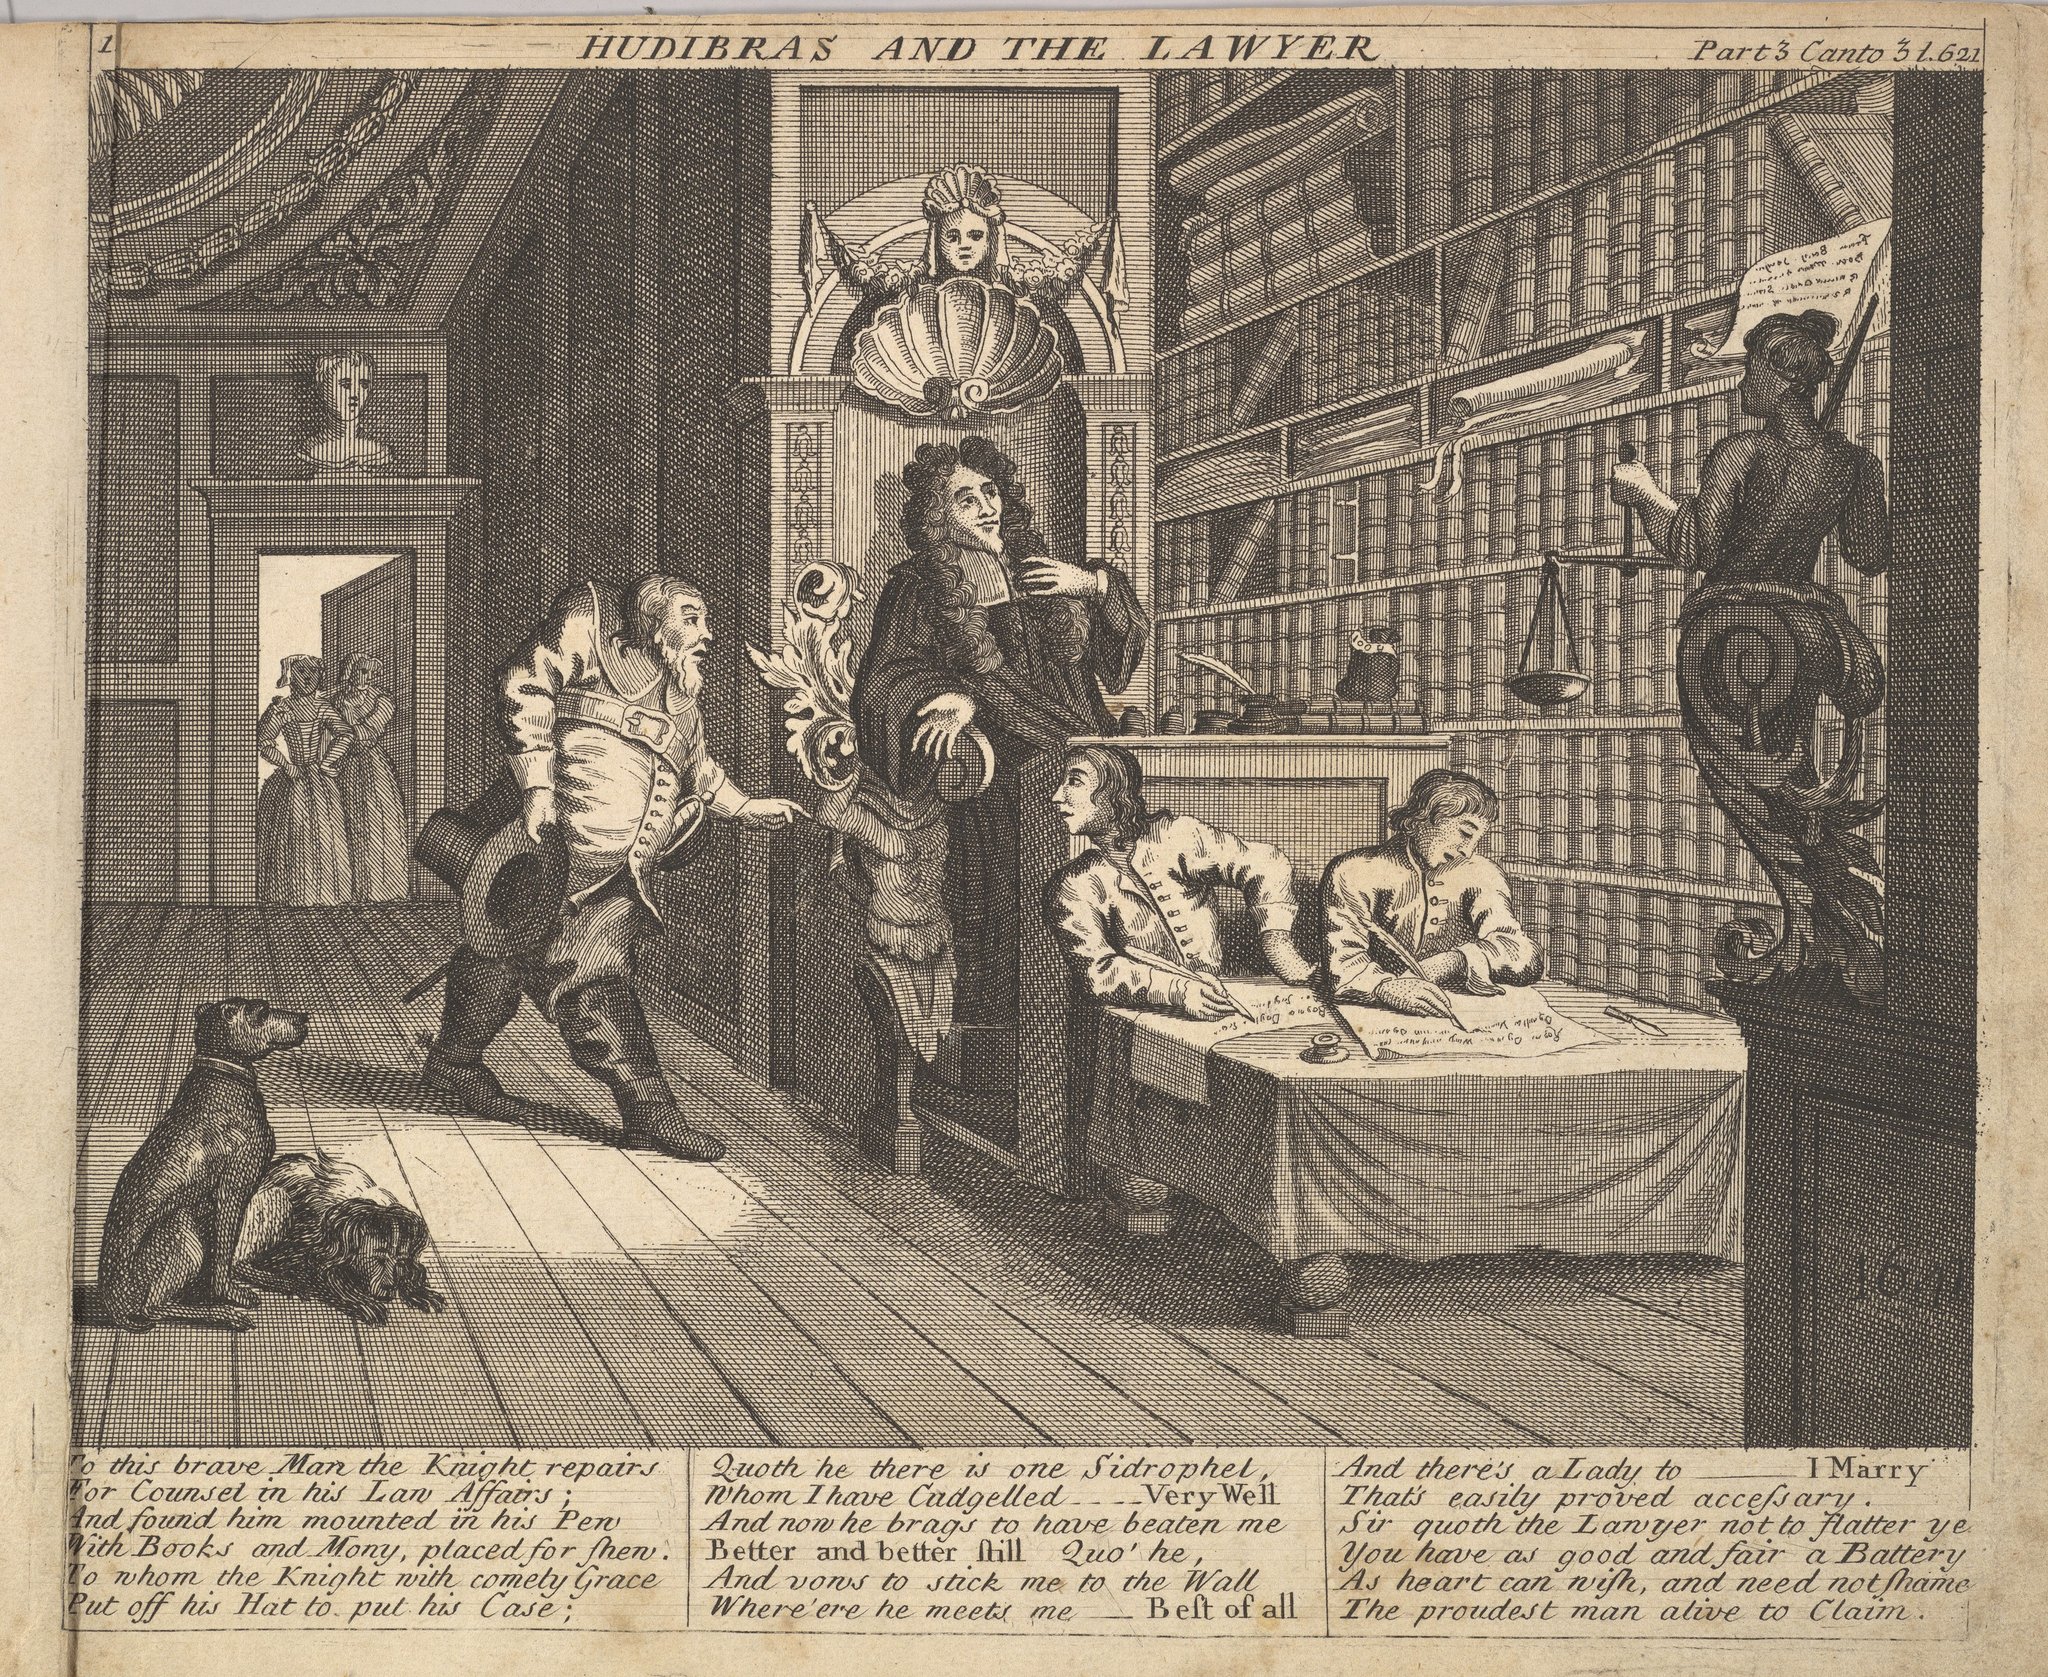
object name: print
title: Hudibras and the Lawyer (Plate 12: Illustrations to Samuel Butler's Hudibras)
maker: william hogarth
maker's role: artist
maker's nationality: british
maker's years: 1697-1764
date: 1725-1730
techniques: engraving, etching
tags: interiors,men,women,dogs,writing